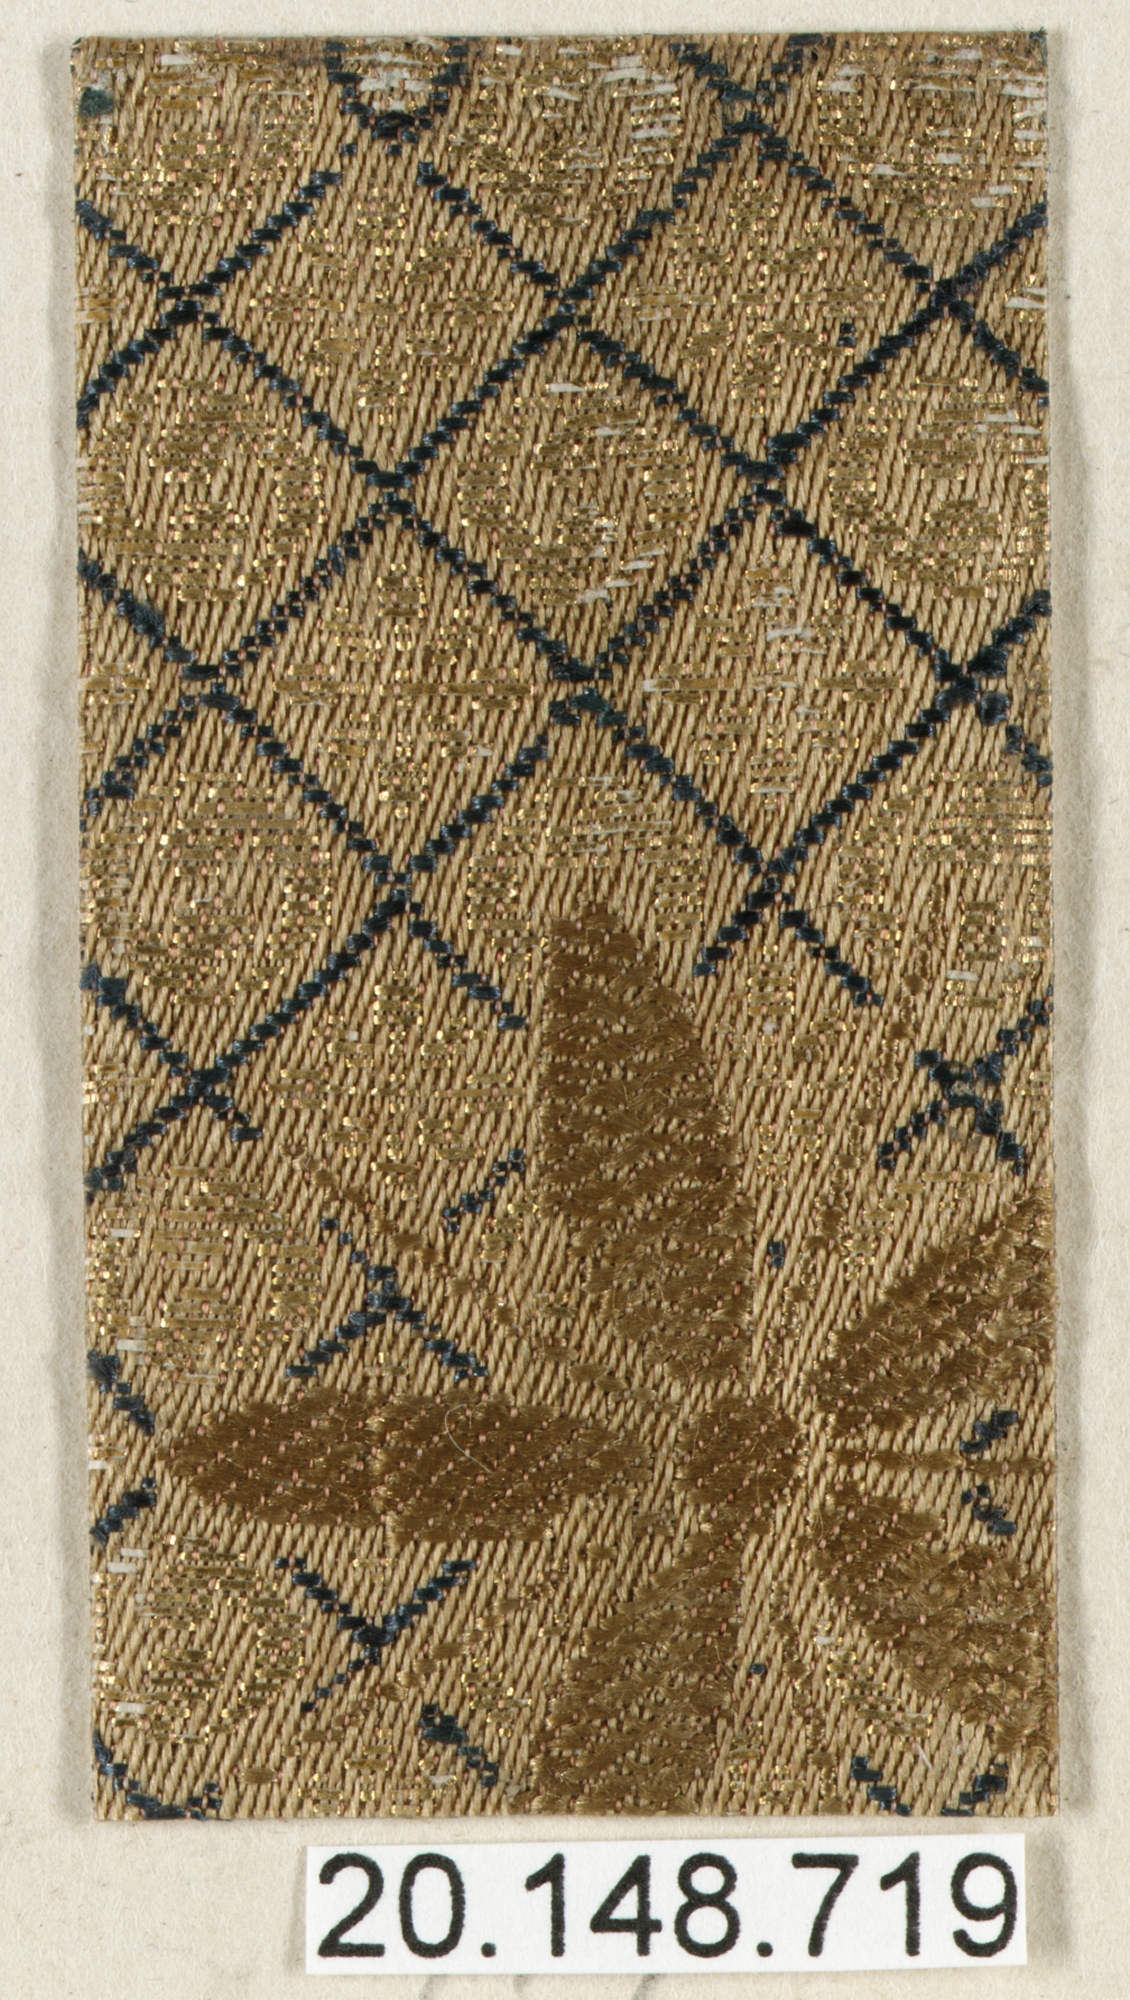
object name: piece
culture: japanese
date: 1701-1800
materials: silk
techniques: compound weave